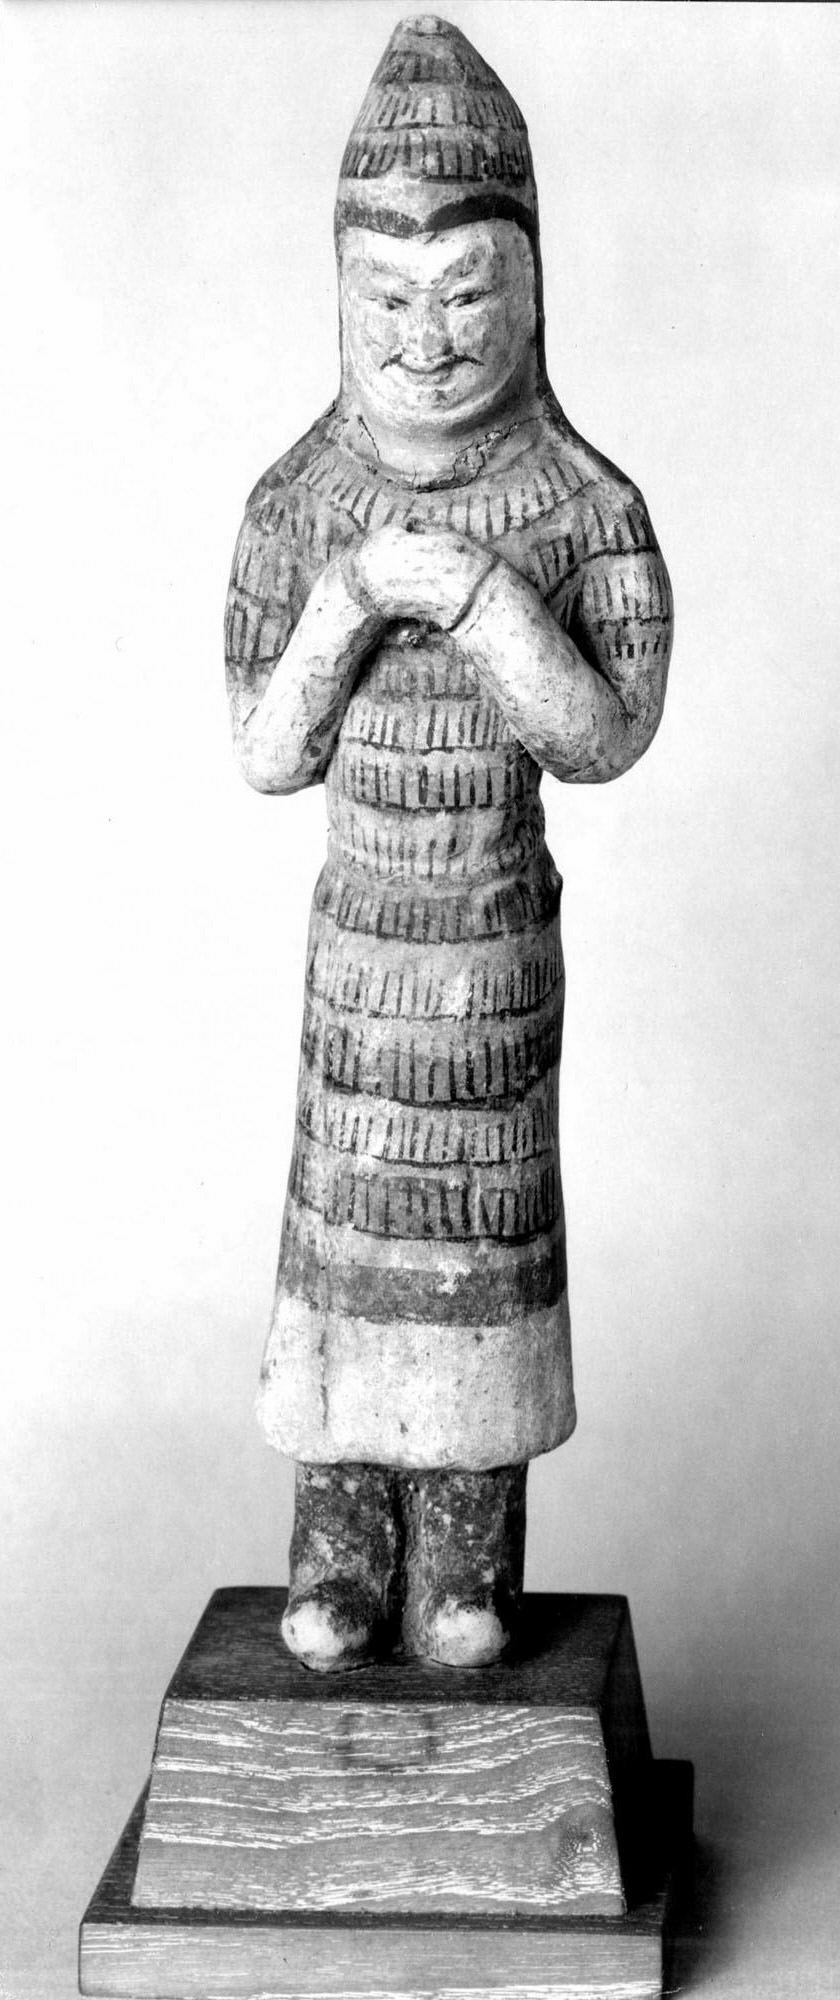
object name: figure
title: Warrior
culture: chinese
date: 601-700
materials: clay, pigment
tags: soldiers